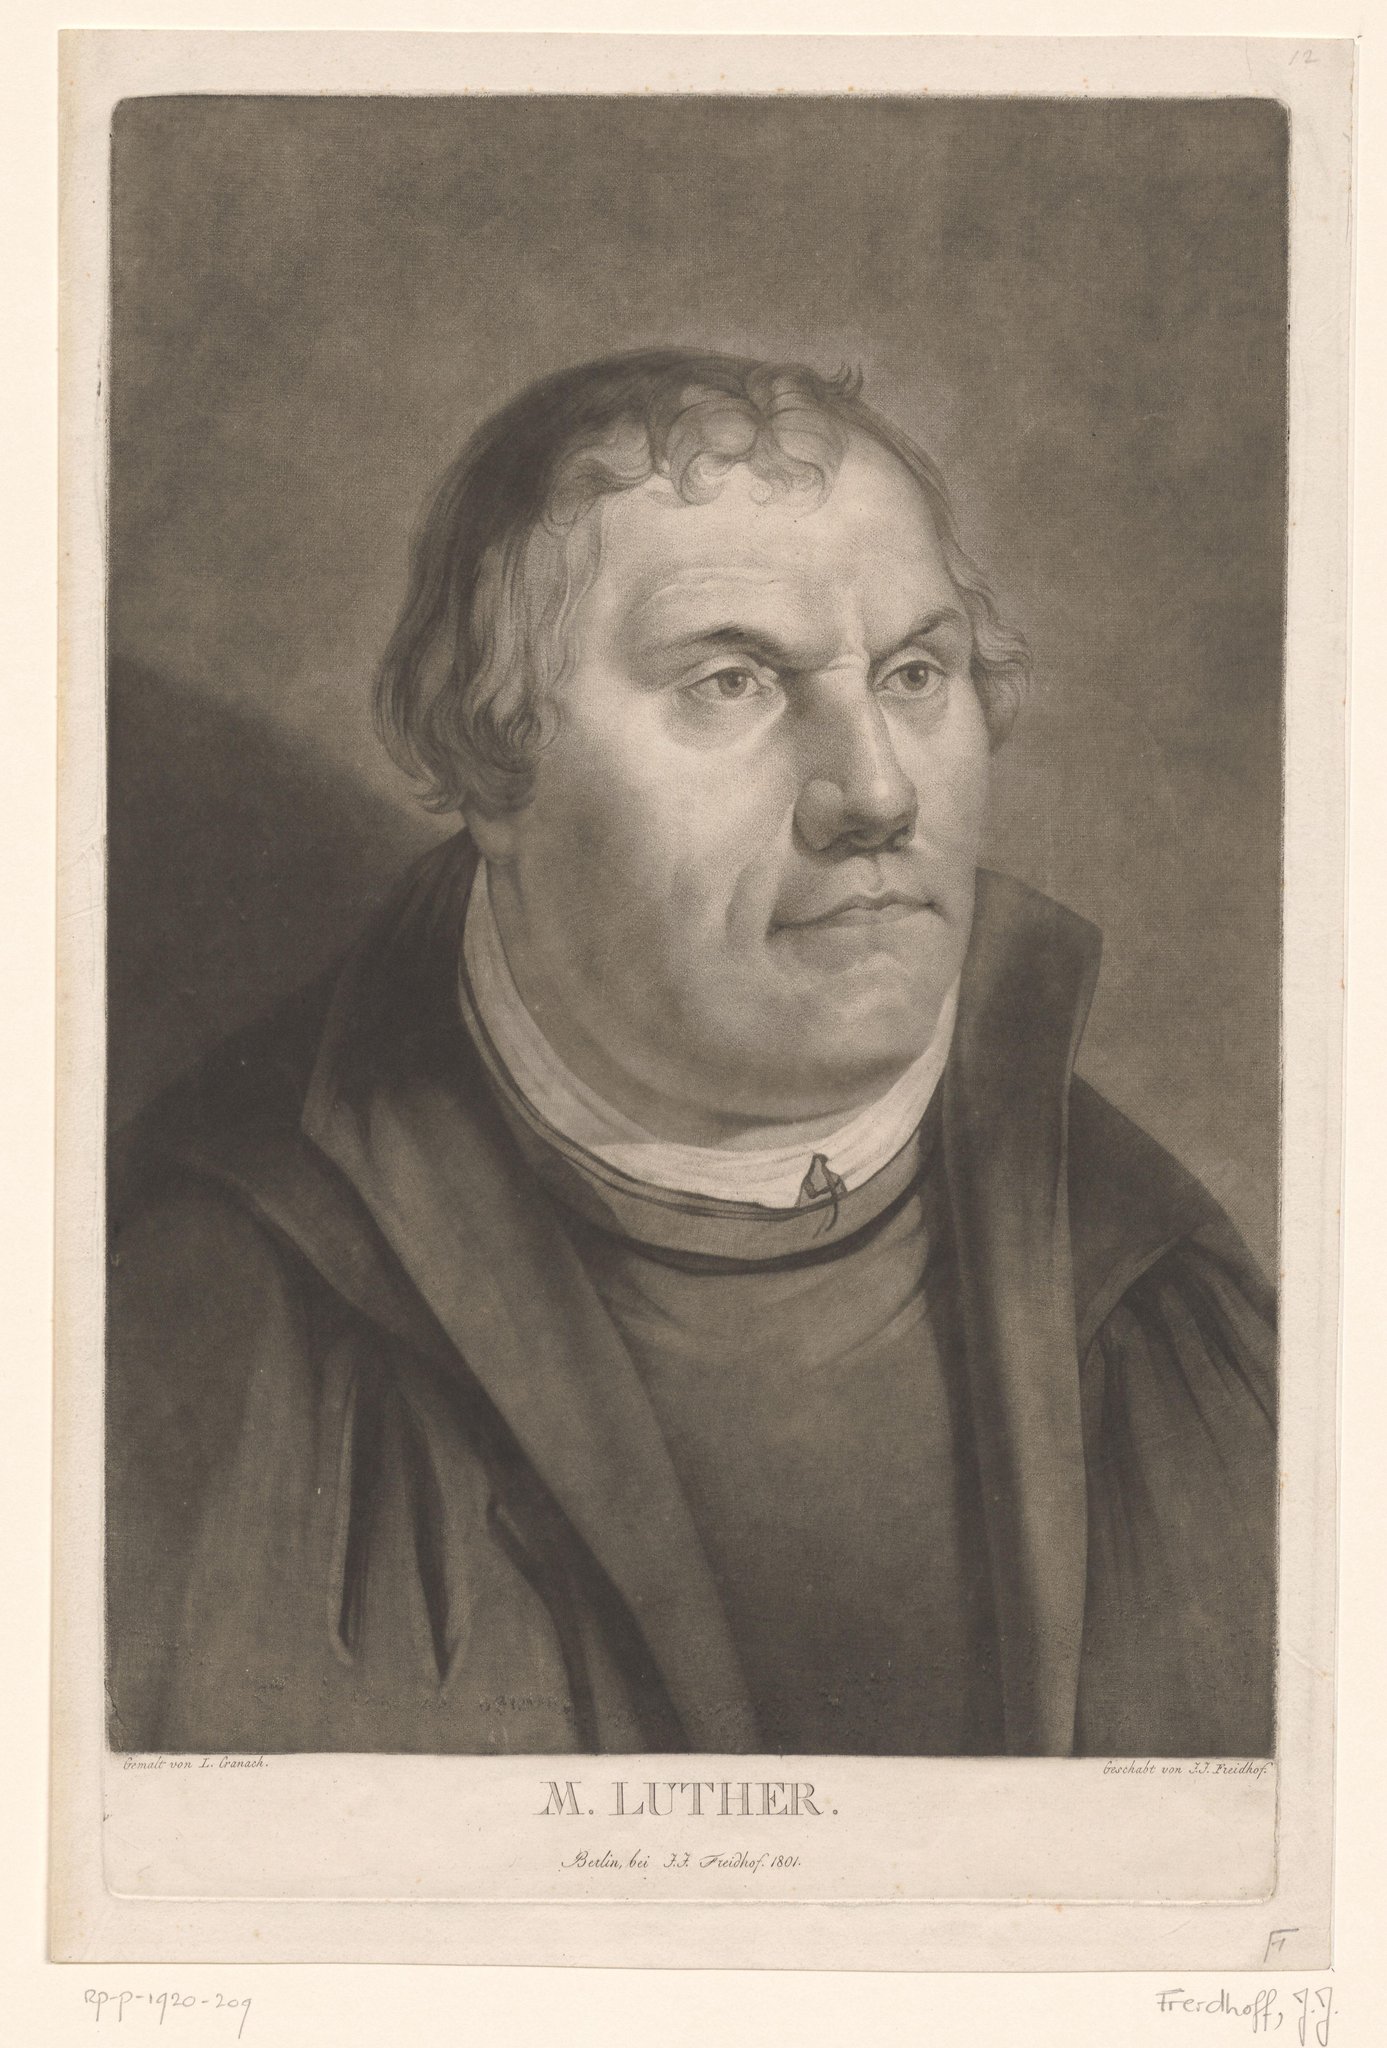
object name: print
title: Portret van Martin Luther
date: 1801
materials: paper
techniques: engraving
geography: berlin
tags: priest, martin luther, protestant churches and denominations, historical persons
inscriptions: collector's mark: Lugt 2228